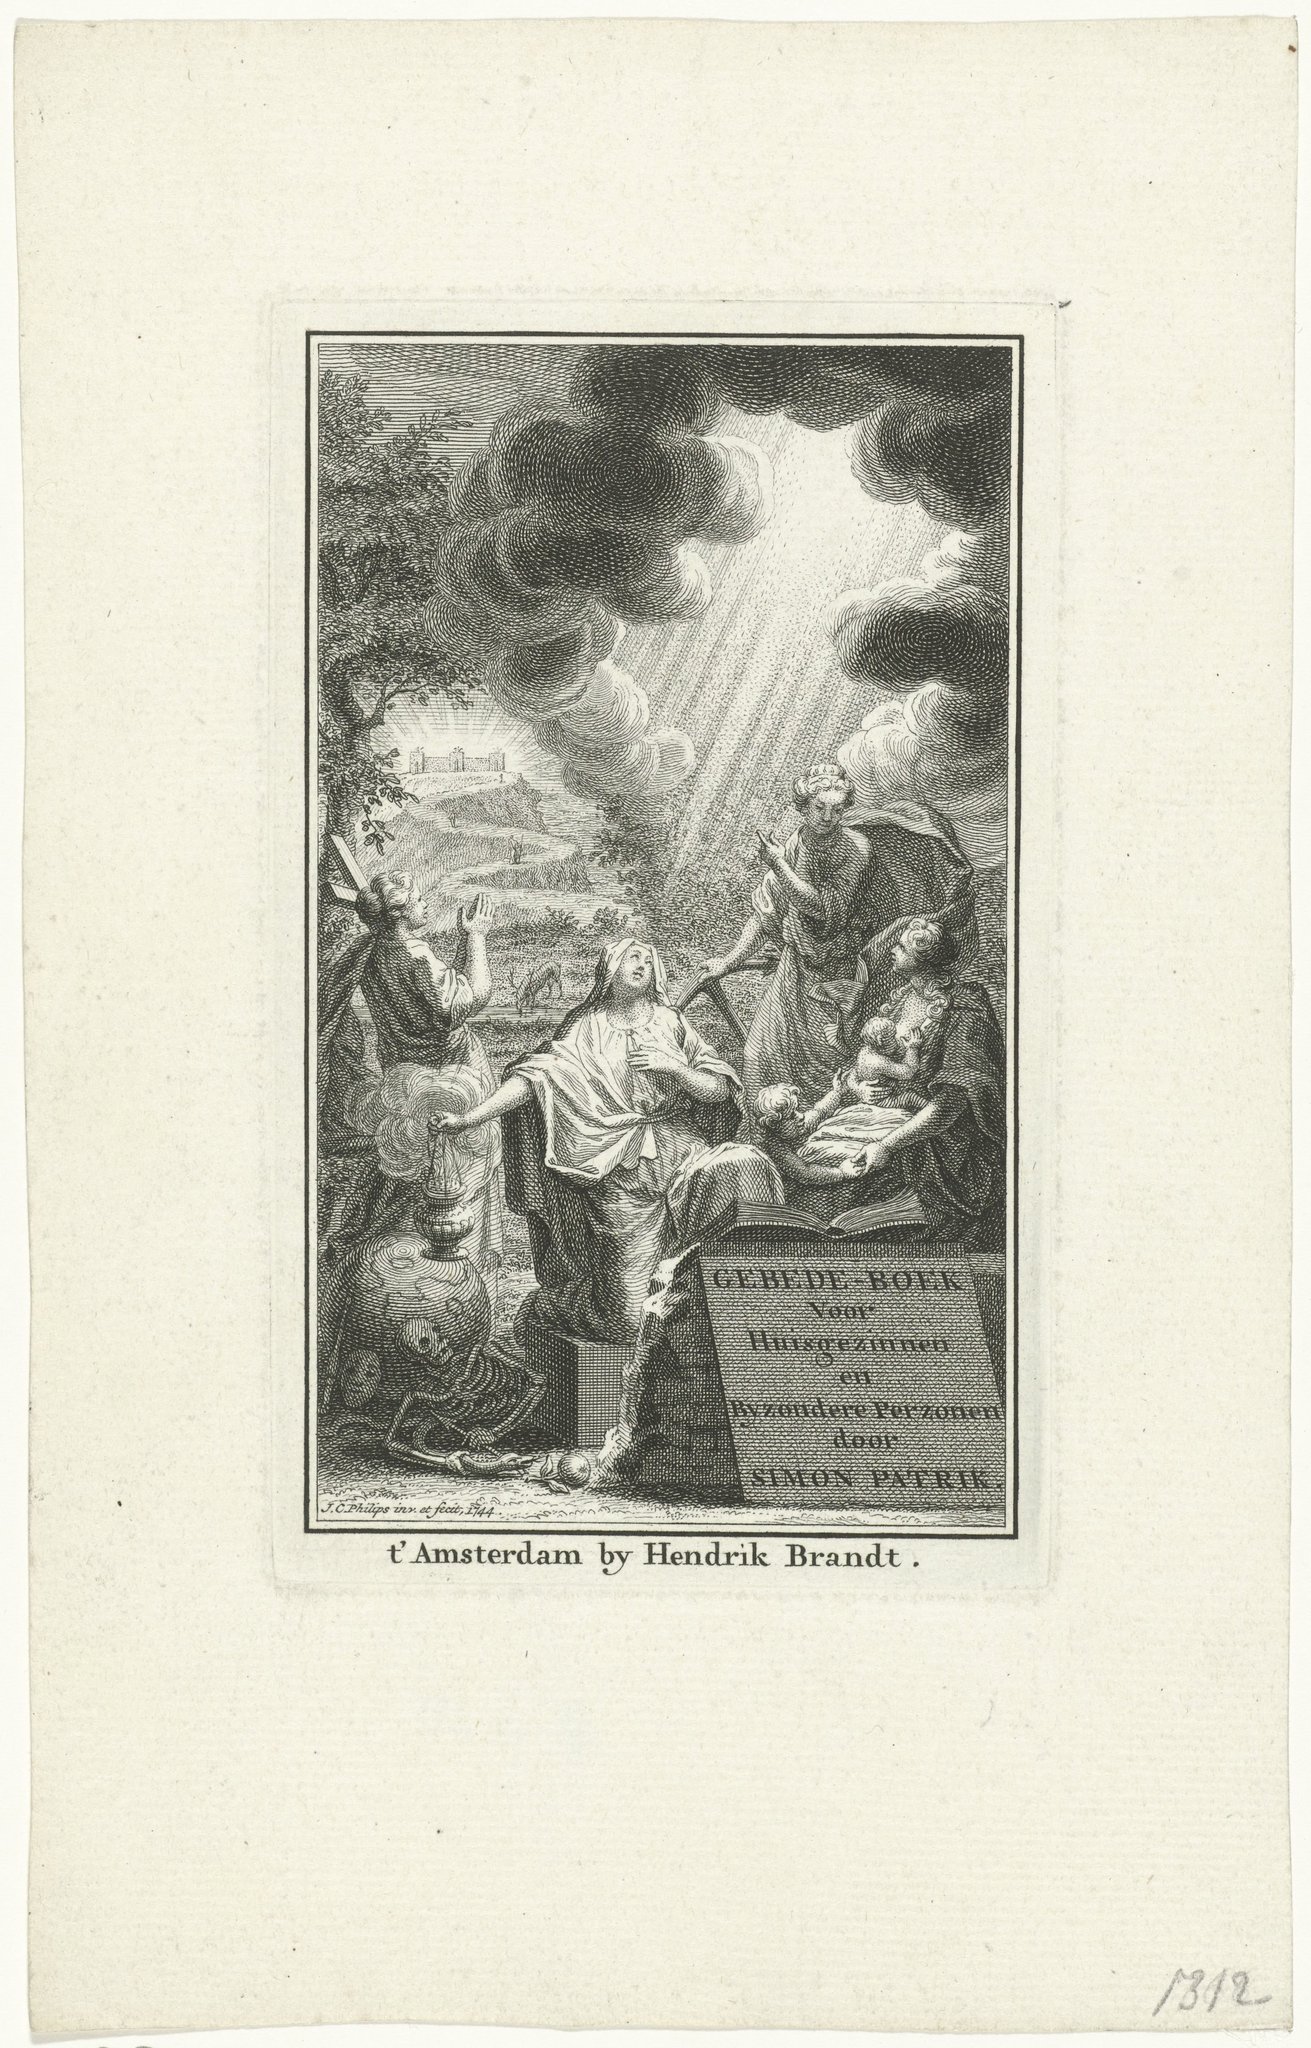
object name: print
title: Titelpagina voor: S. Patrick, Een gebede-boek voor huisgezinnen en voor byzondere persoonen, 1744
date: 1744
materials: paper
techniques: engraving, etching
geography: amsterdam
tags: adam's tomb, charity, 'caritas'; 'carità' (ripa) ~ one of the three theological virtues, faith, 'fides'; 'fede', 'fede catholica', 'fede christiana', 'fede christiana catholica' (ripa) ~ one of the three theological virtues, hope, 'spes'; 'speranza divina e certa' (ripa) ~ one of the three theological virtues, globe, the worship of god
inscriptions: collector's mark: Lugt 2228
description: Een vrouw knielt voor een opengeslagen bijbel, in haar hand een wierookvat, dat symbool staat voor de gebeden die opstijgen naar de hemel. Ze wordt vergezeld door personificaties van de drie goddelijke deugden. Hoop (Spes), leunend op een anker, wijst de zogende Liefde (Caritas), op de goddelijke lichtstralen uit de hemel. Geloof (Fides) kijkt in aanbidding op naar de hemel. Links op de voorgrond een skelet met een slang en de appel, die verwijzen naar de zondeval. Op de achtergrond op een heuvel de tempel te Jeruzalem. Rechts op de voorgrond een tablet waarop de titel in het Nederlands.